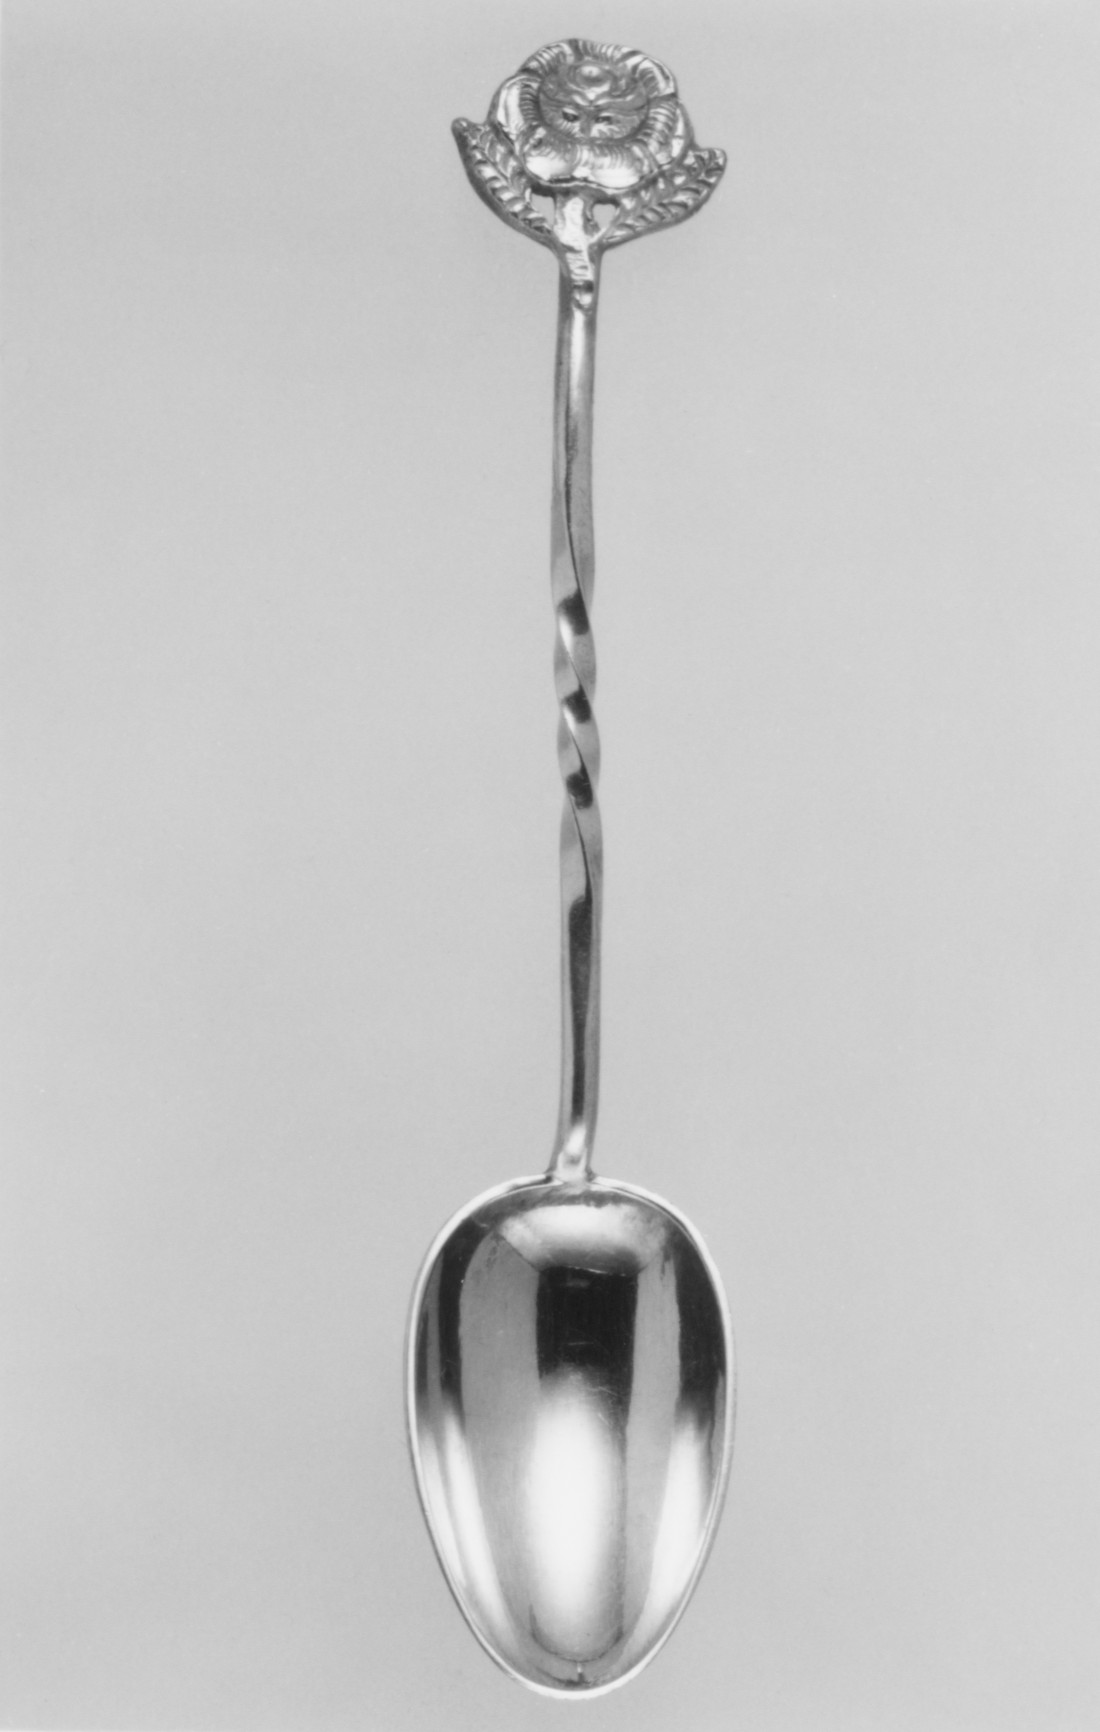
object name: souvenir spoon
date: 1867-1900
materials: silver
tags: flowers